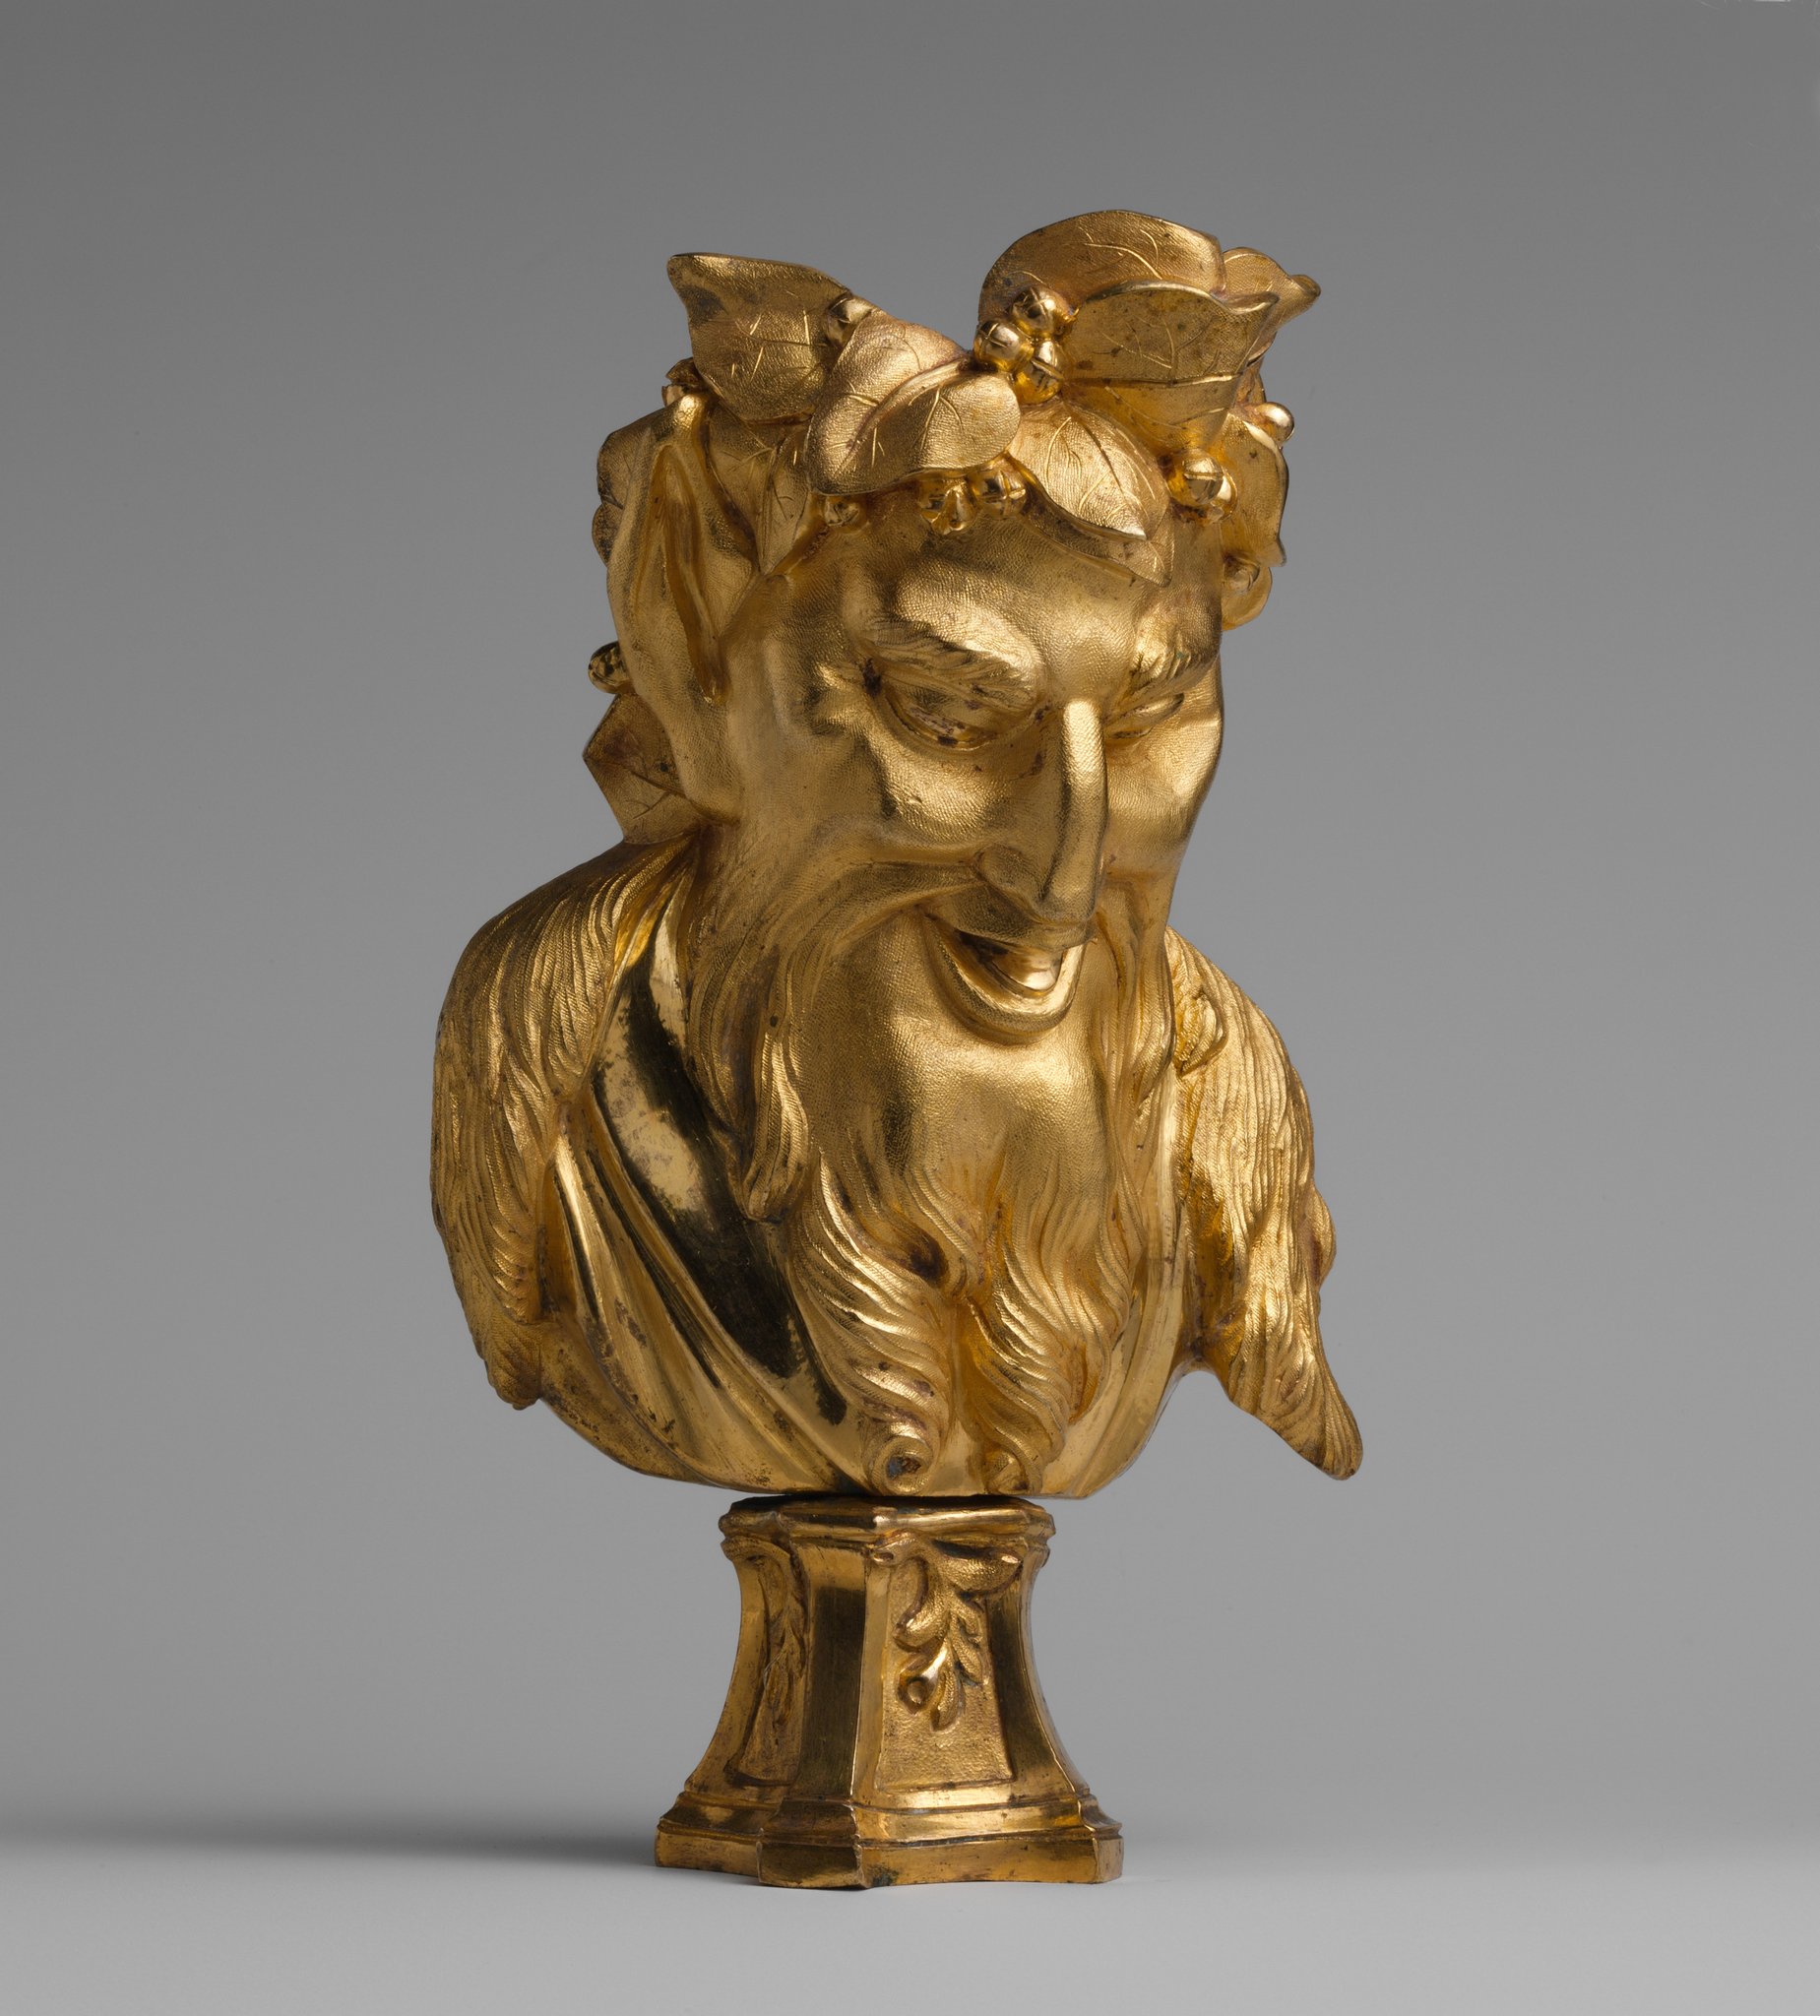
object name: bust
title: Pair of busts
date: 1780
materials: gilt bronze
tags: heads,men